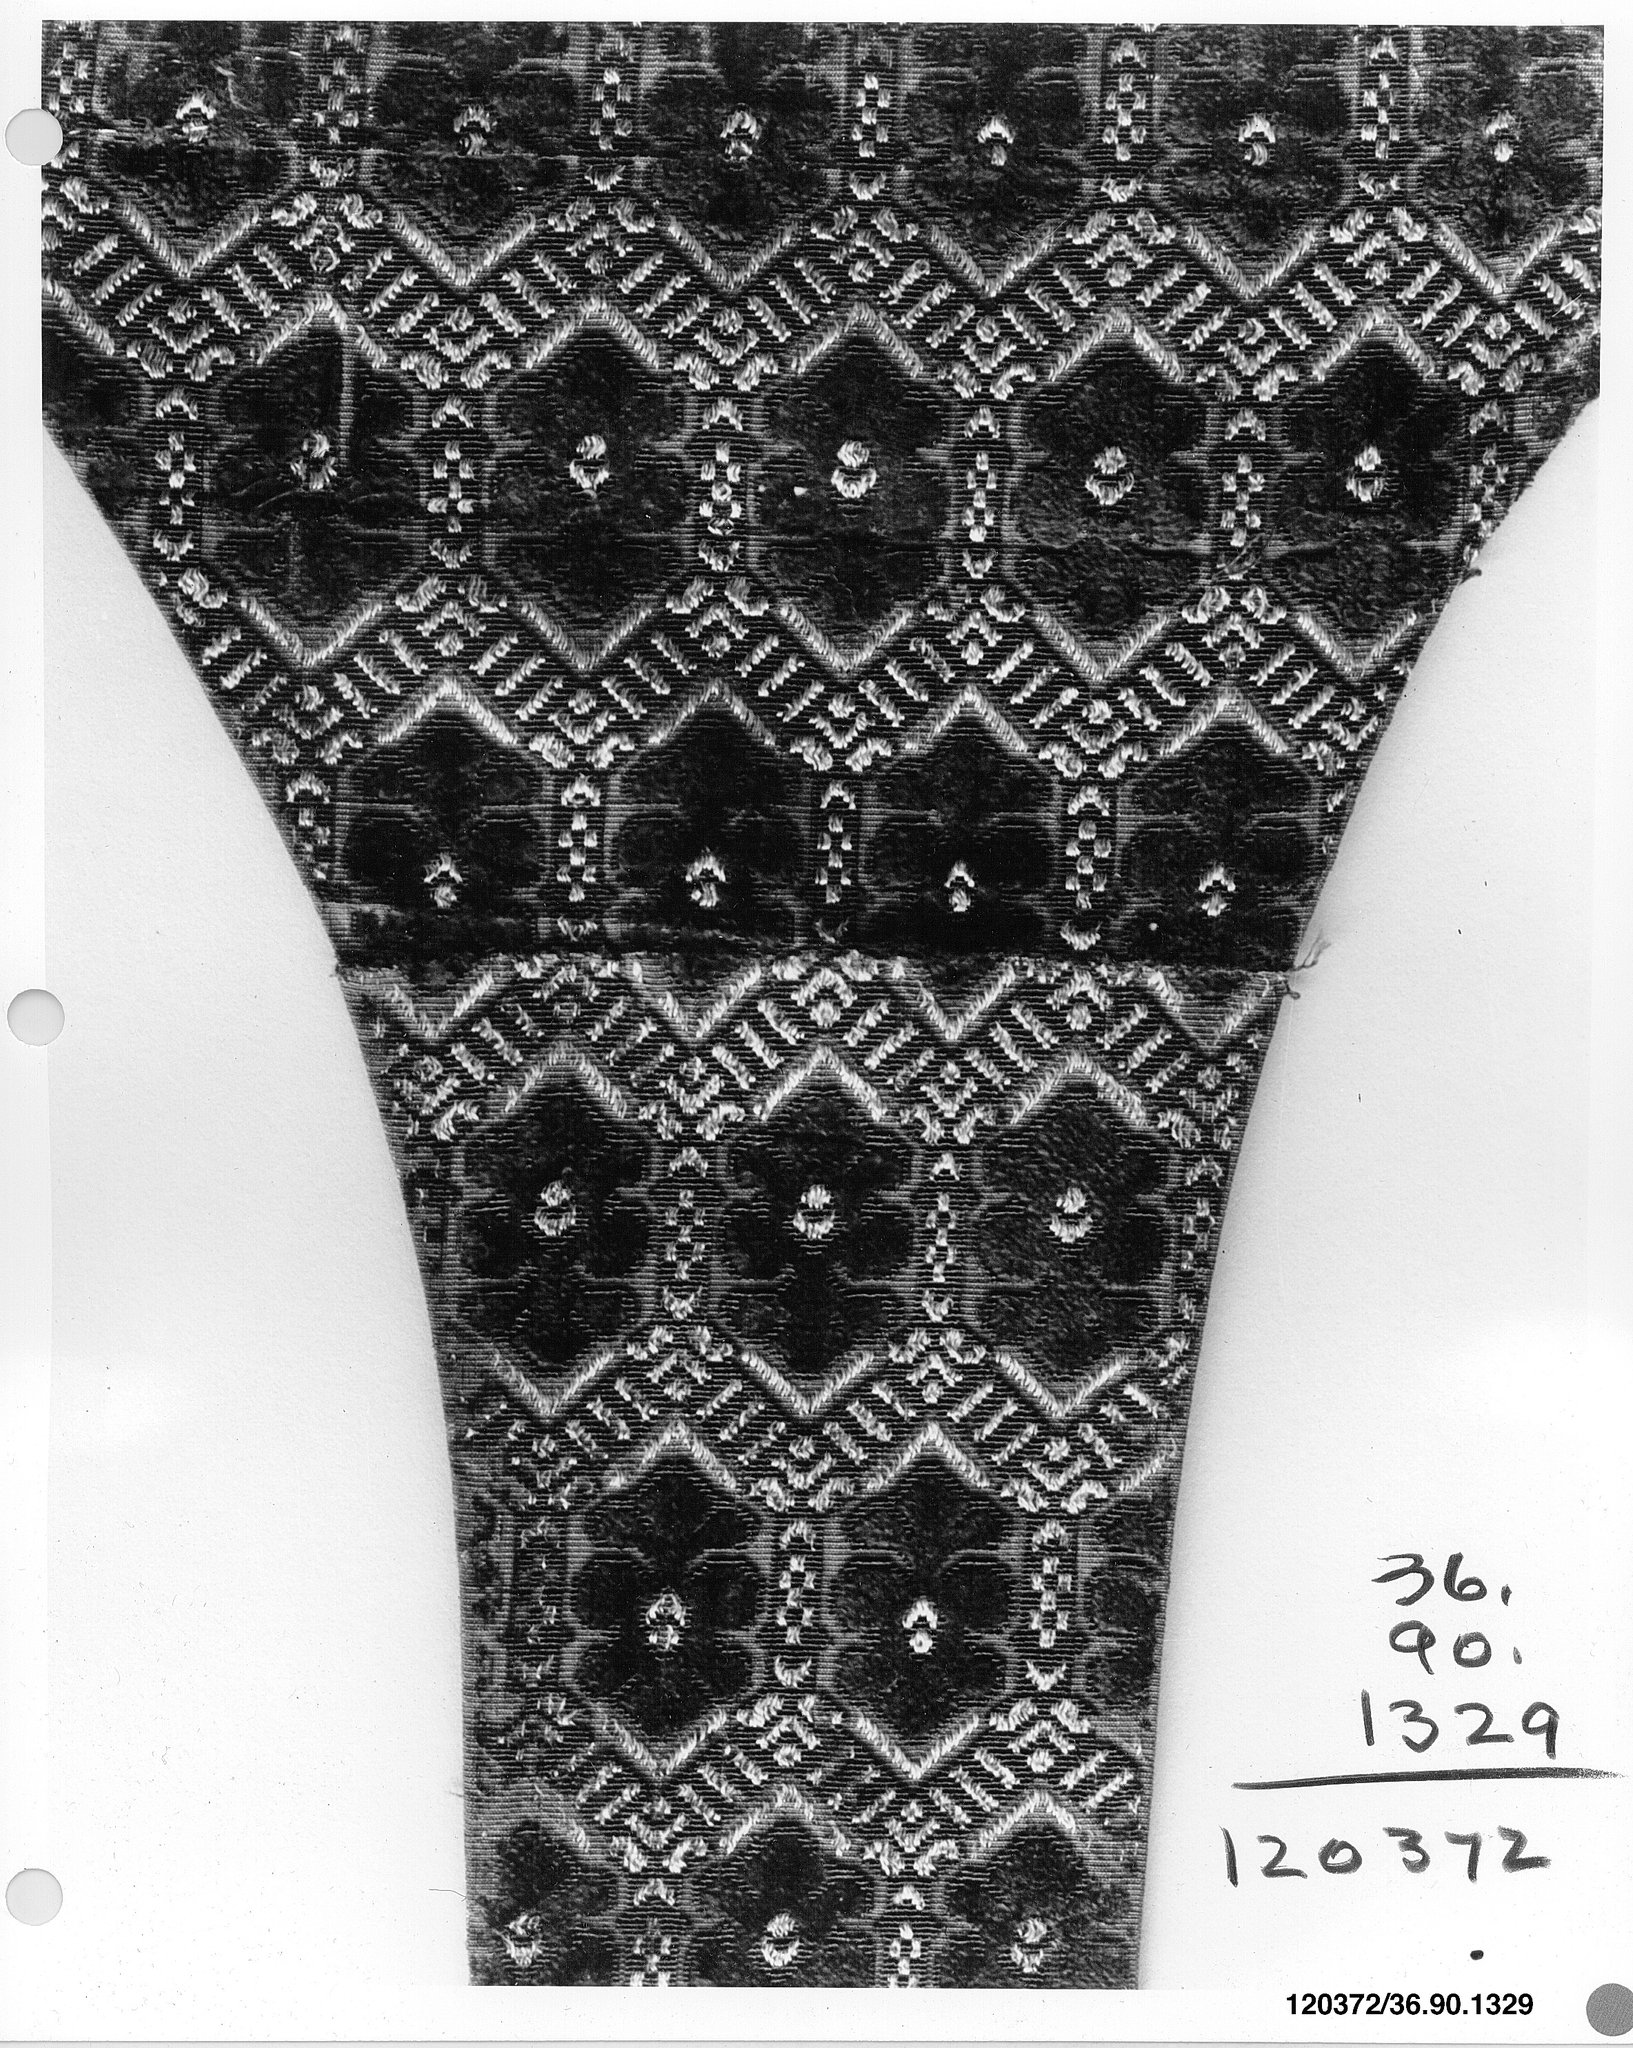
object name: piece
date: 1501-1700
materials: silk